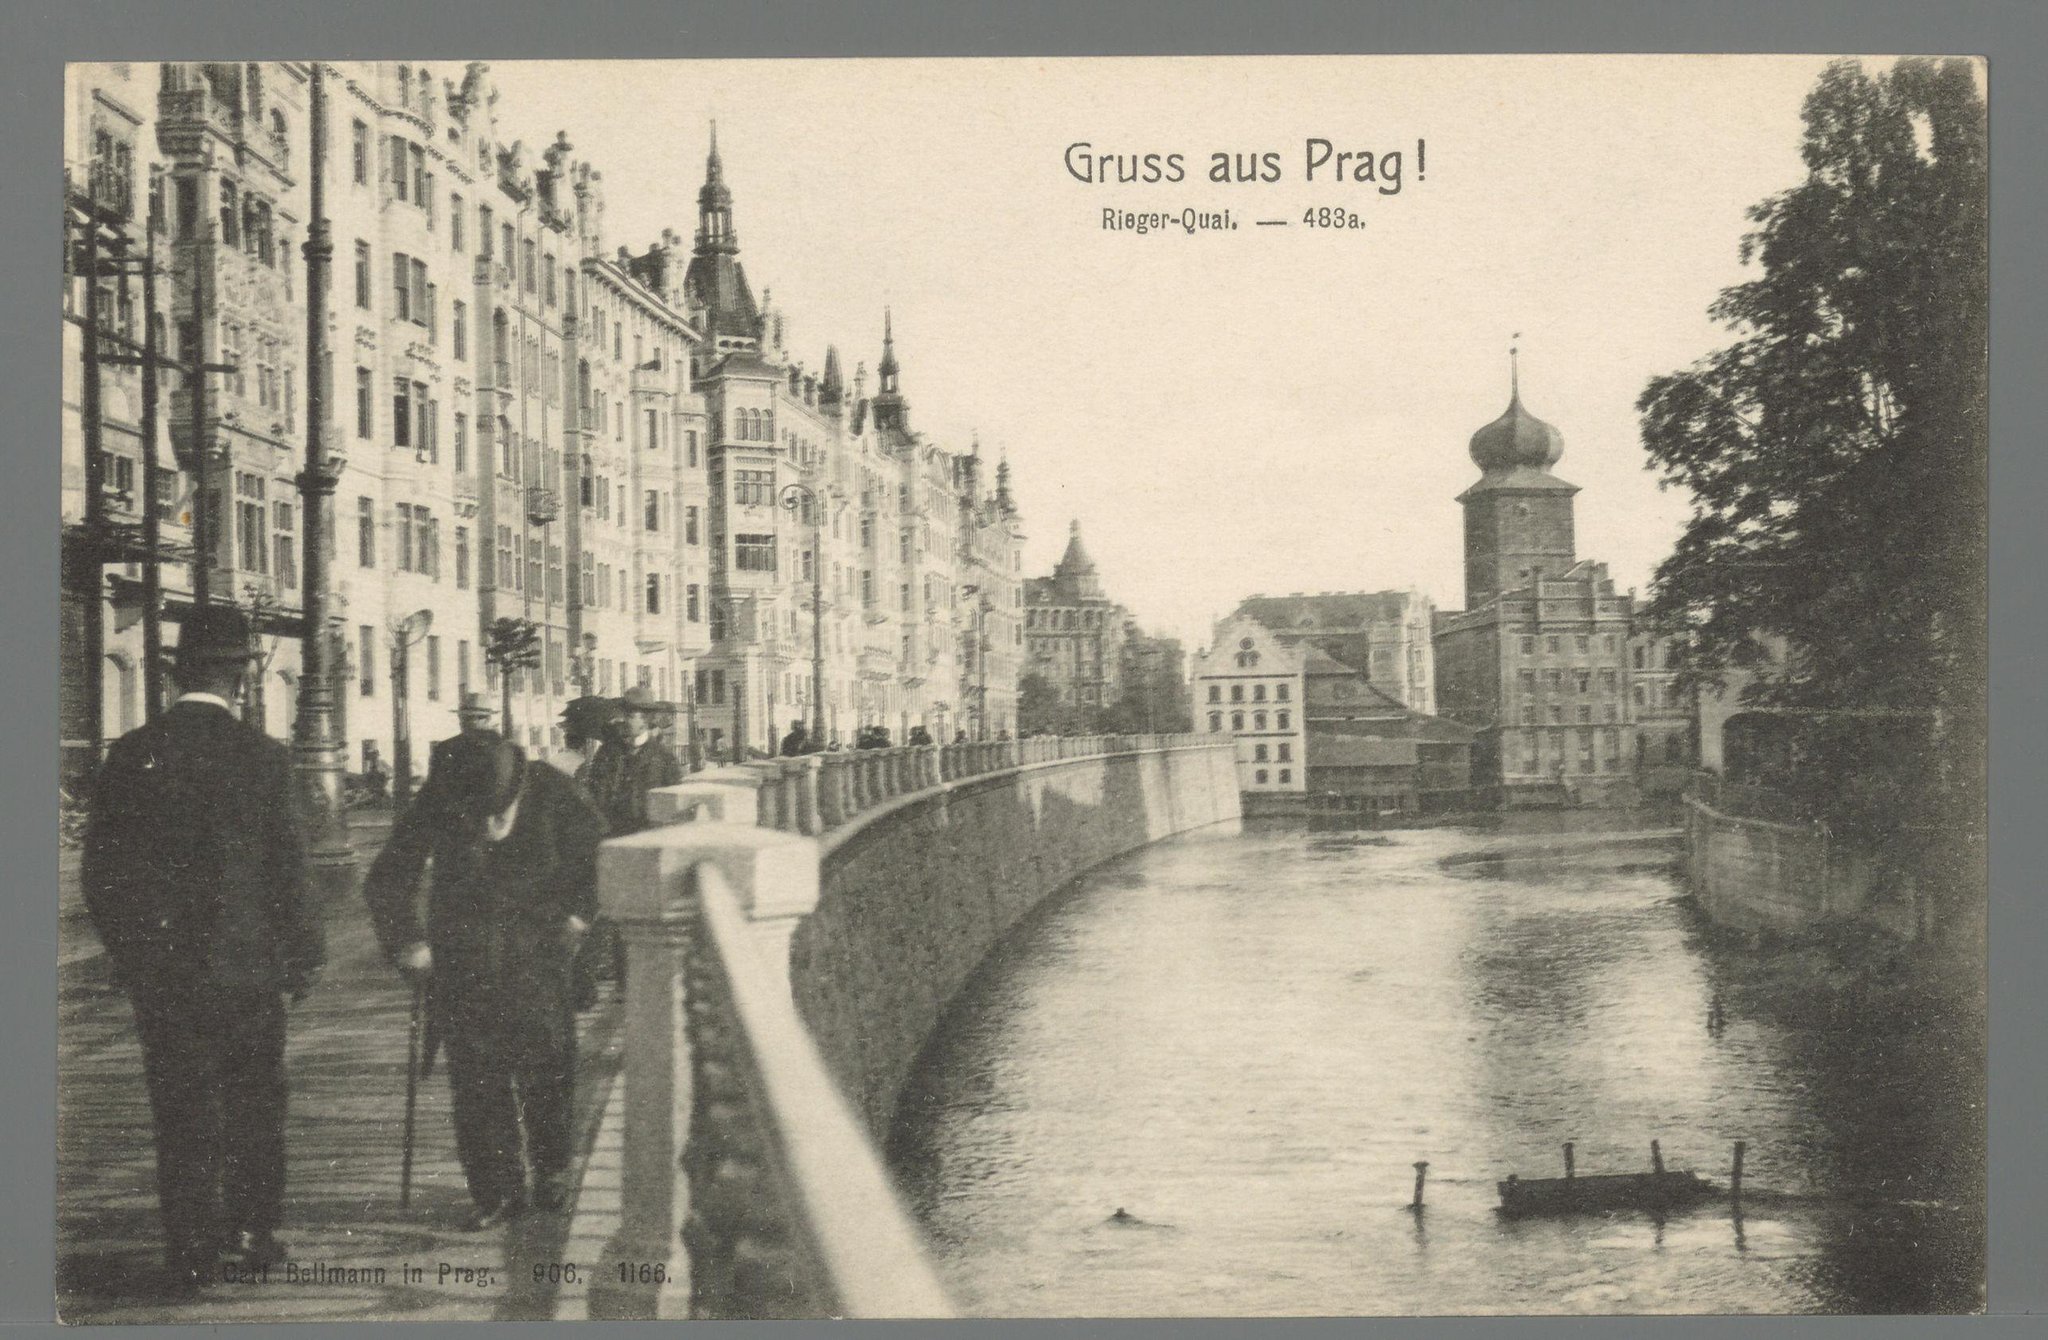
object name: photomechanical print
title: Gruss aus Prag! Rieger-Quai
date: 1906-1910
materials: cardboard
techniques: photograph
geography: prague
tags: canals, waters (in city), quay, prague